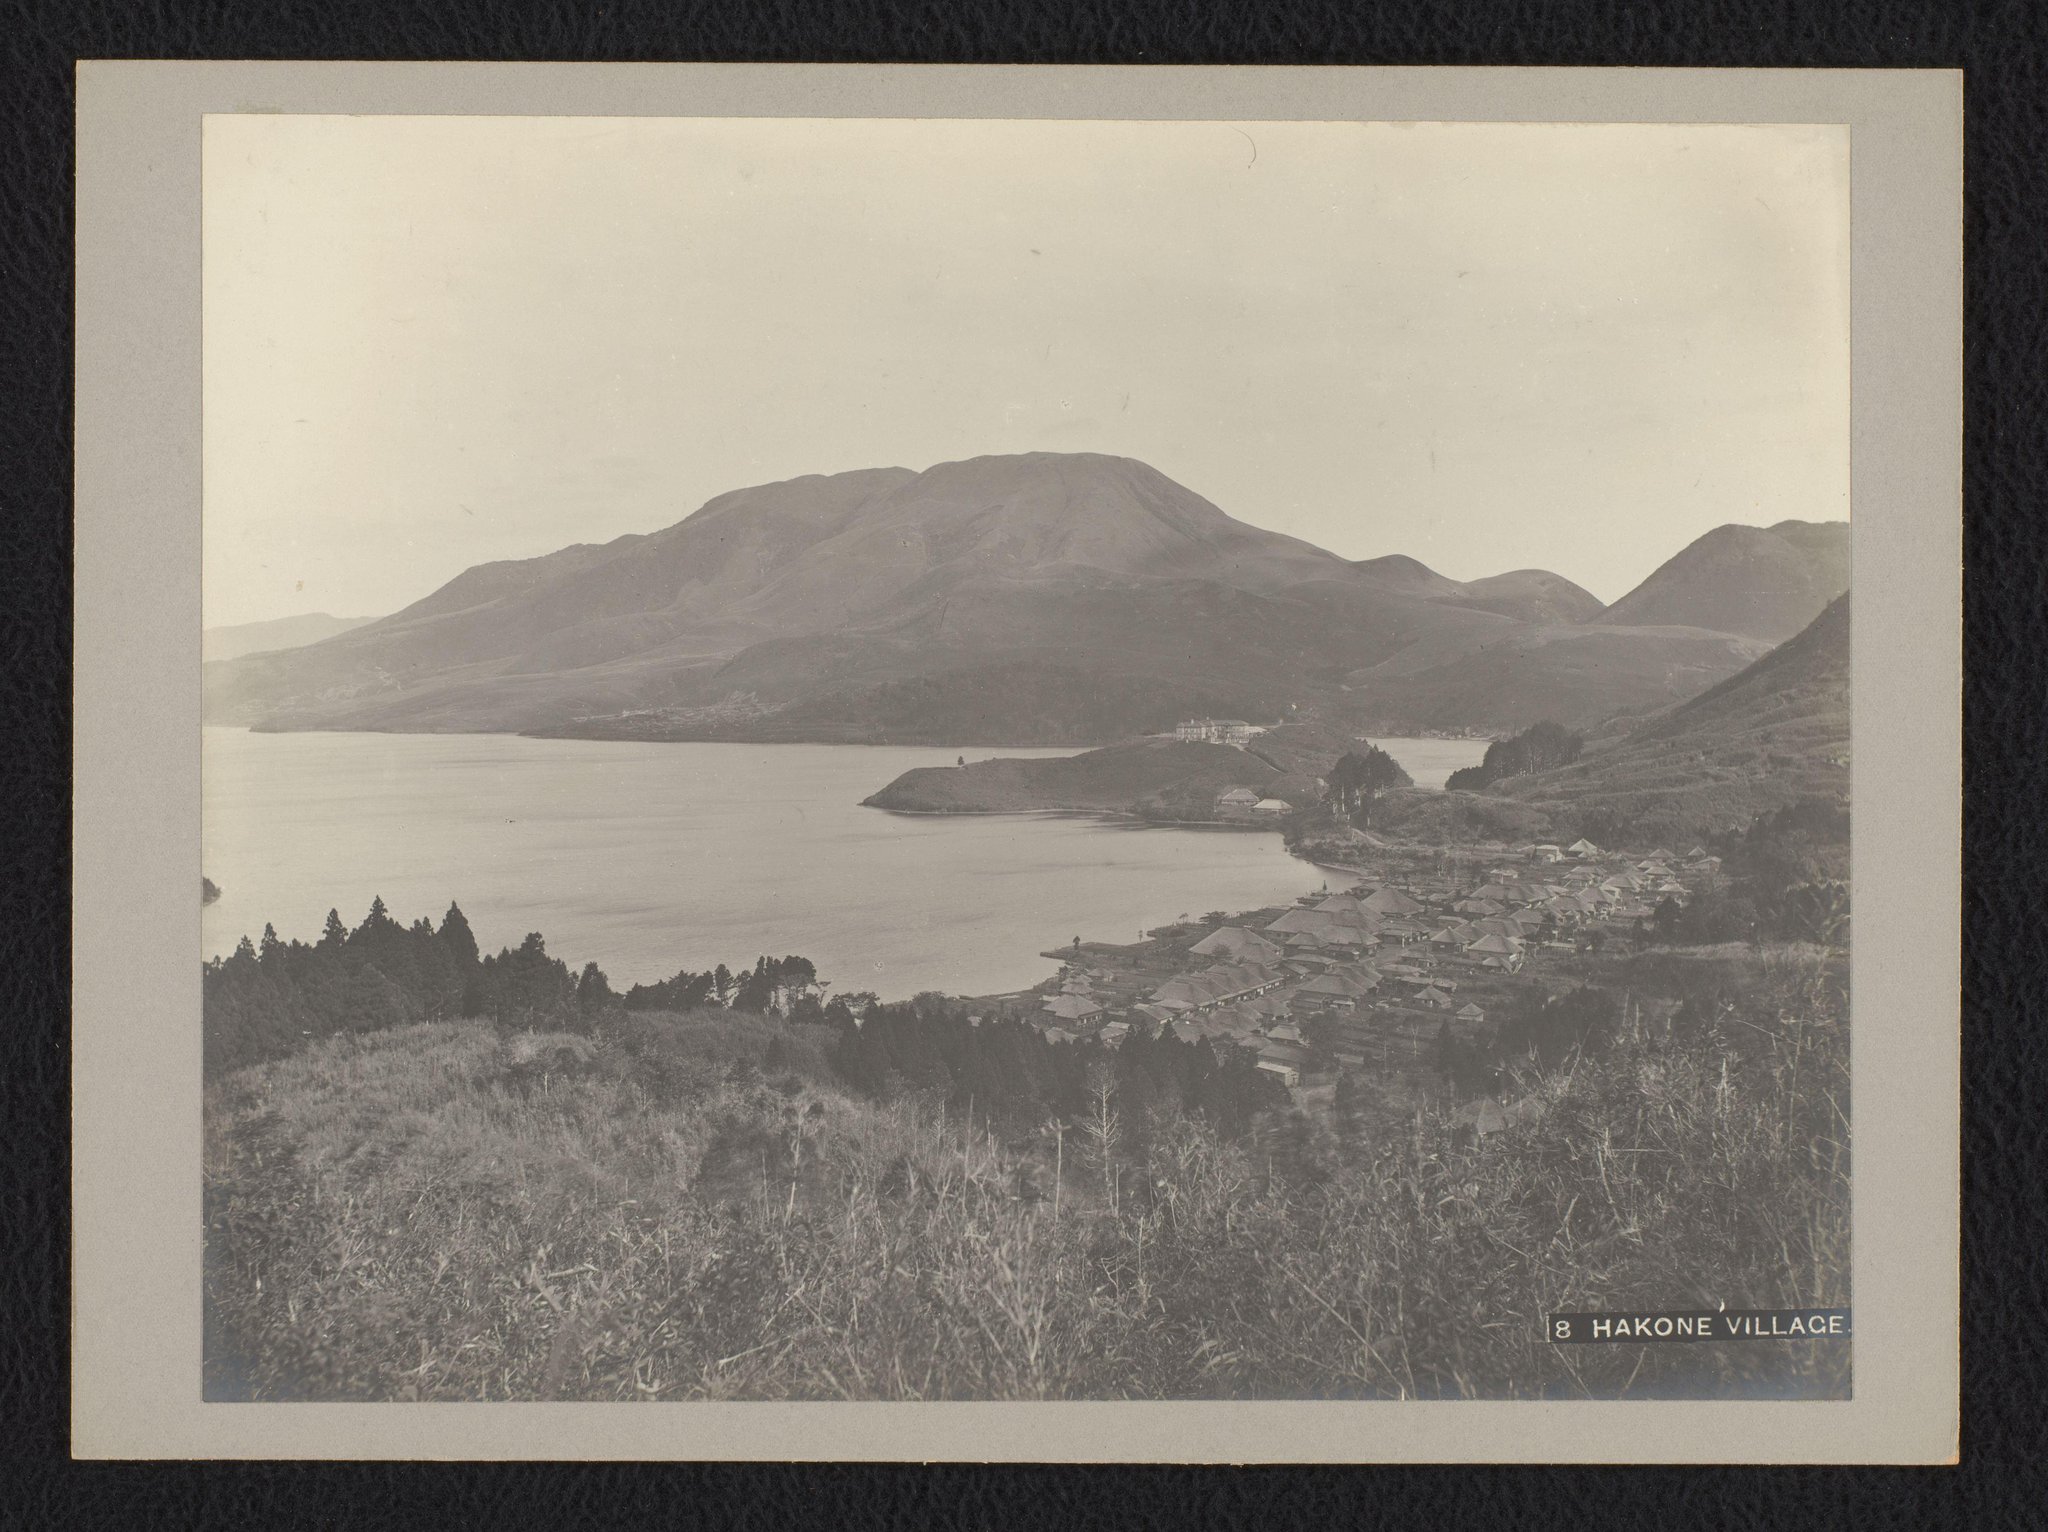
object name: photograph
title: Uitzicht op dorp en Hakonemeer, Hakone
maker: Anonymous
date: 1895-1915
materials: cardboard, photographic support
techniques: gelatin silver print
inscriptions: number: ‘24.’